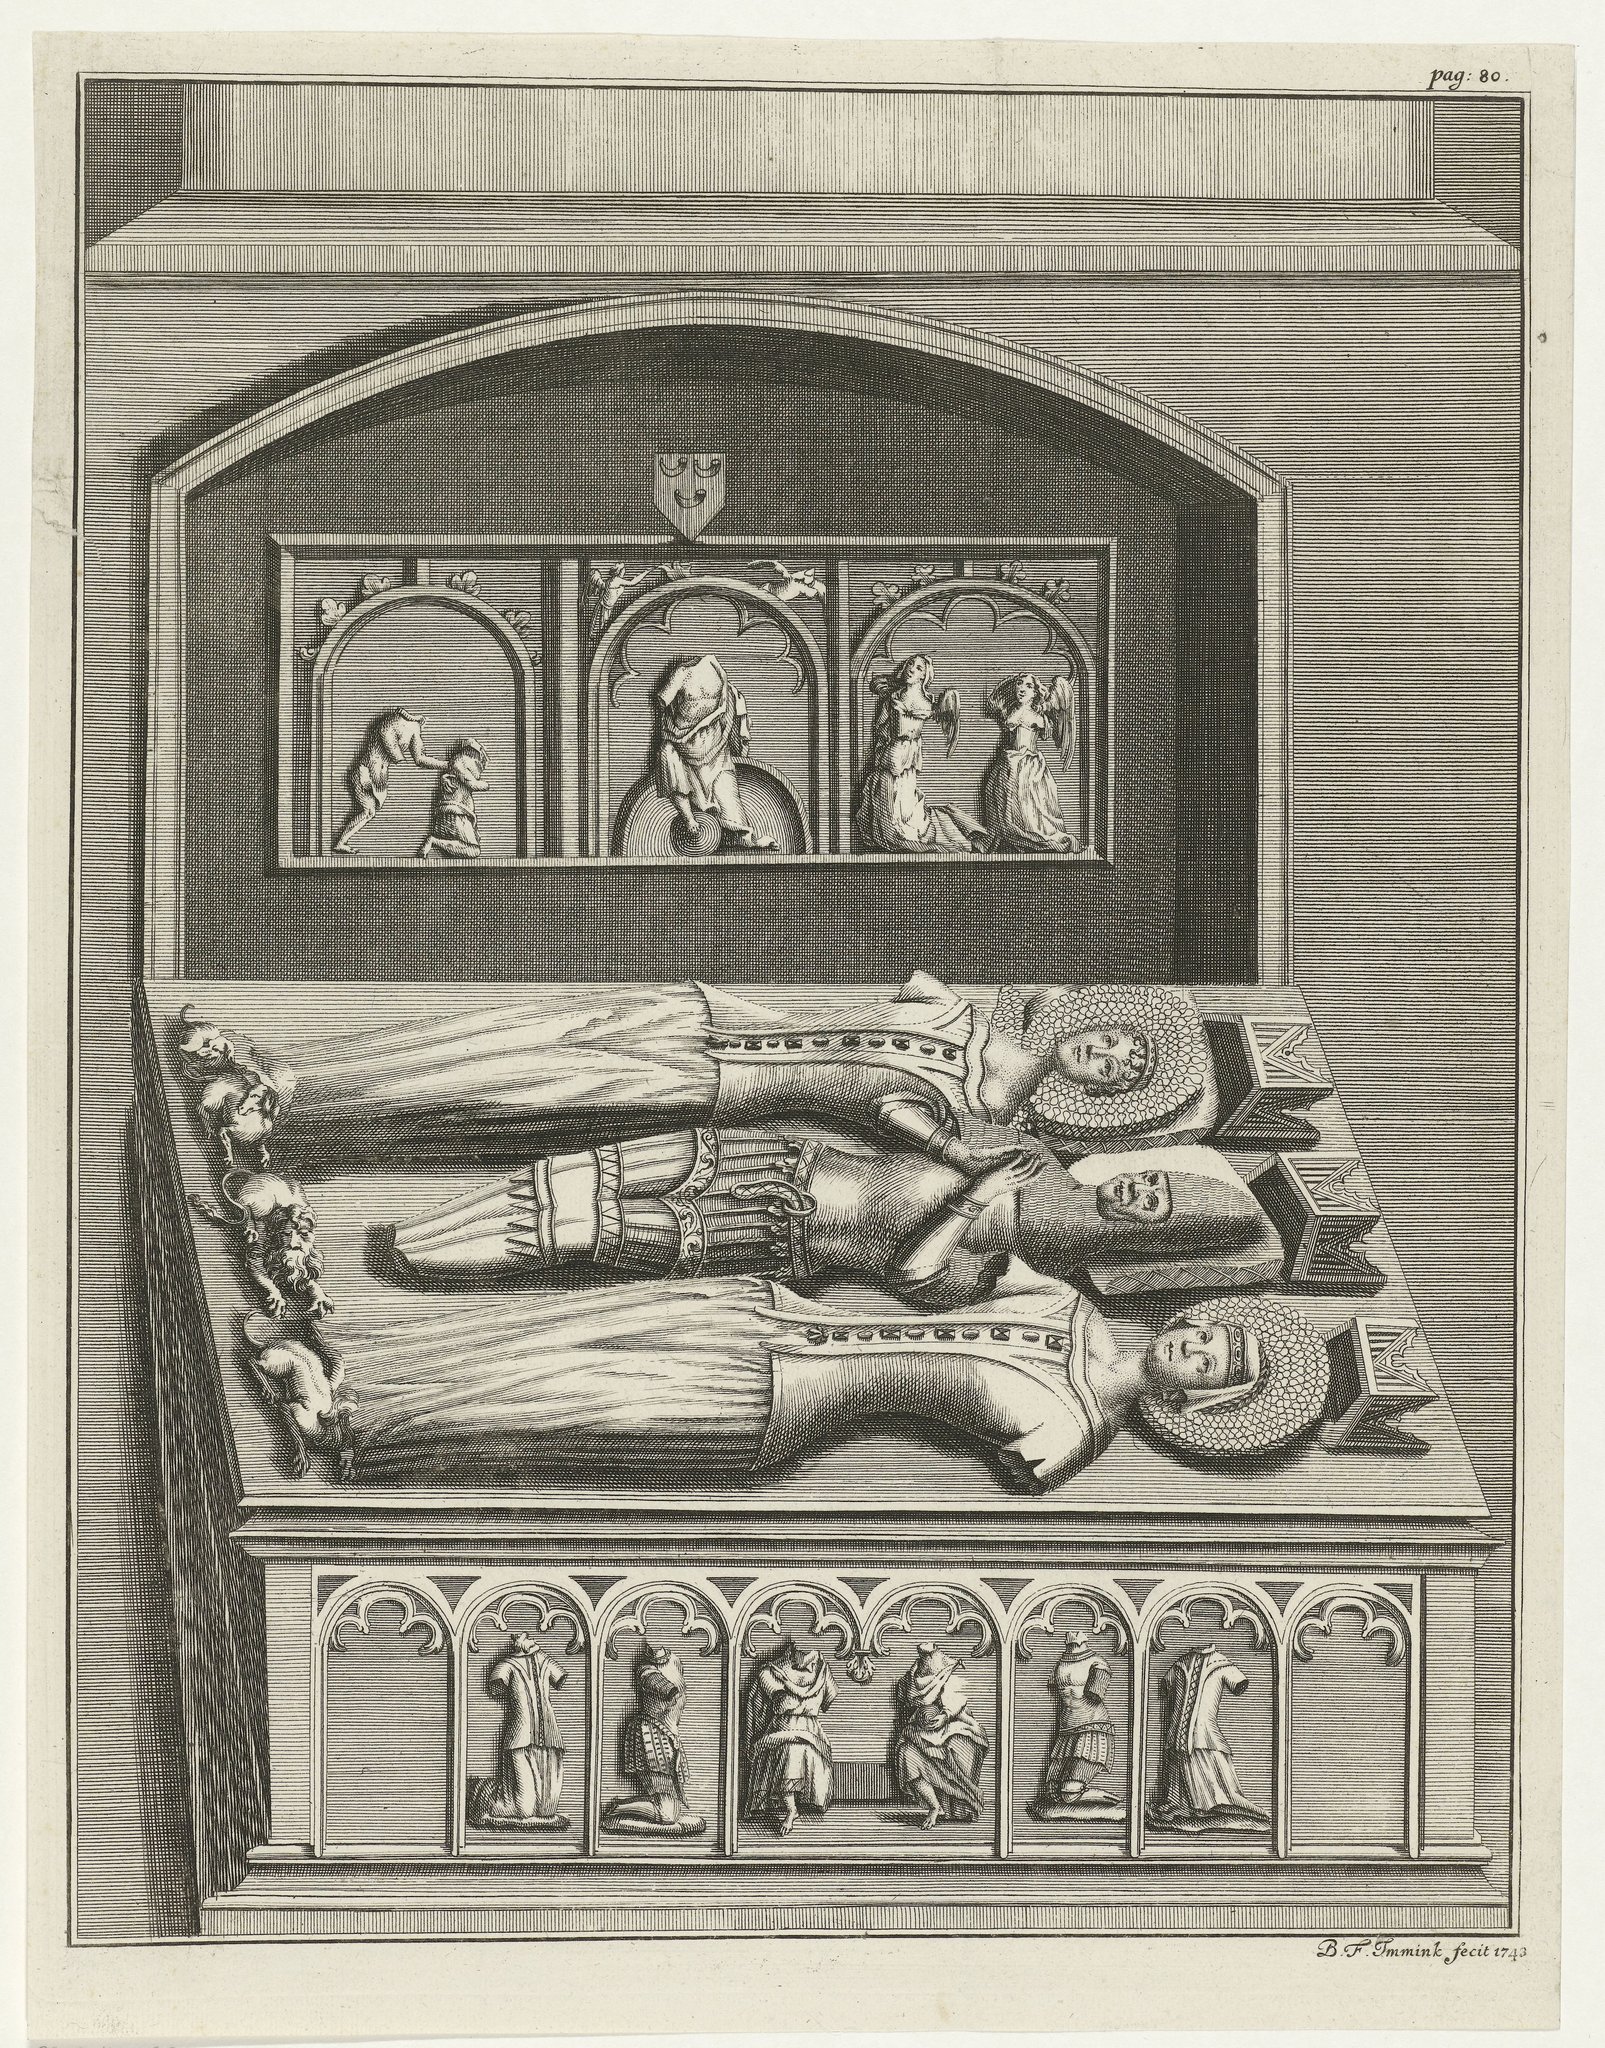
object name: print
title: Grafmonument van Jan II van Polanen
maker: b.f. immink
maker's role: print maker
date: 1743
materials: paper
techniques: engraving, etching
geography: the hague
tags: grave, tomb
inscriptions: collector's mark: Lugt 2228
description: Boven en vooraanzicht van het grafmonument van Jan II van Polanen en zijn vrouwen. Op het grafmonument het liggende beeld van de overledene, temidden van de beelden van zijn eerste en tweede vrouw, Oda de Hornes en Machteld van Rootselaer. Het grafmonument bevindt zich in de Grote Kerk te Breda. Rechtsboven: pag: 80. Prent uit een boek over Breda.